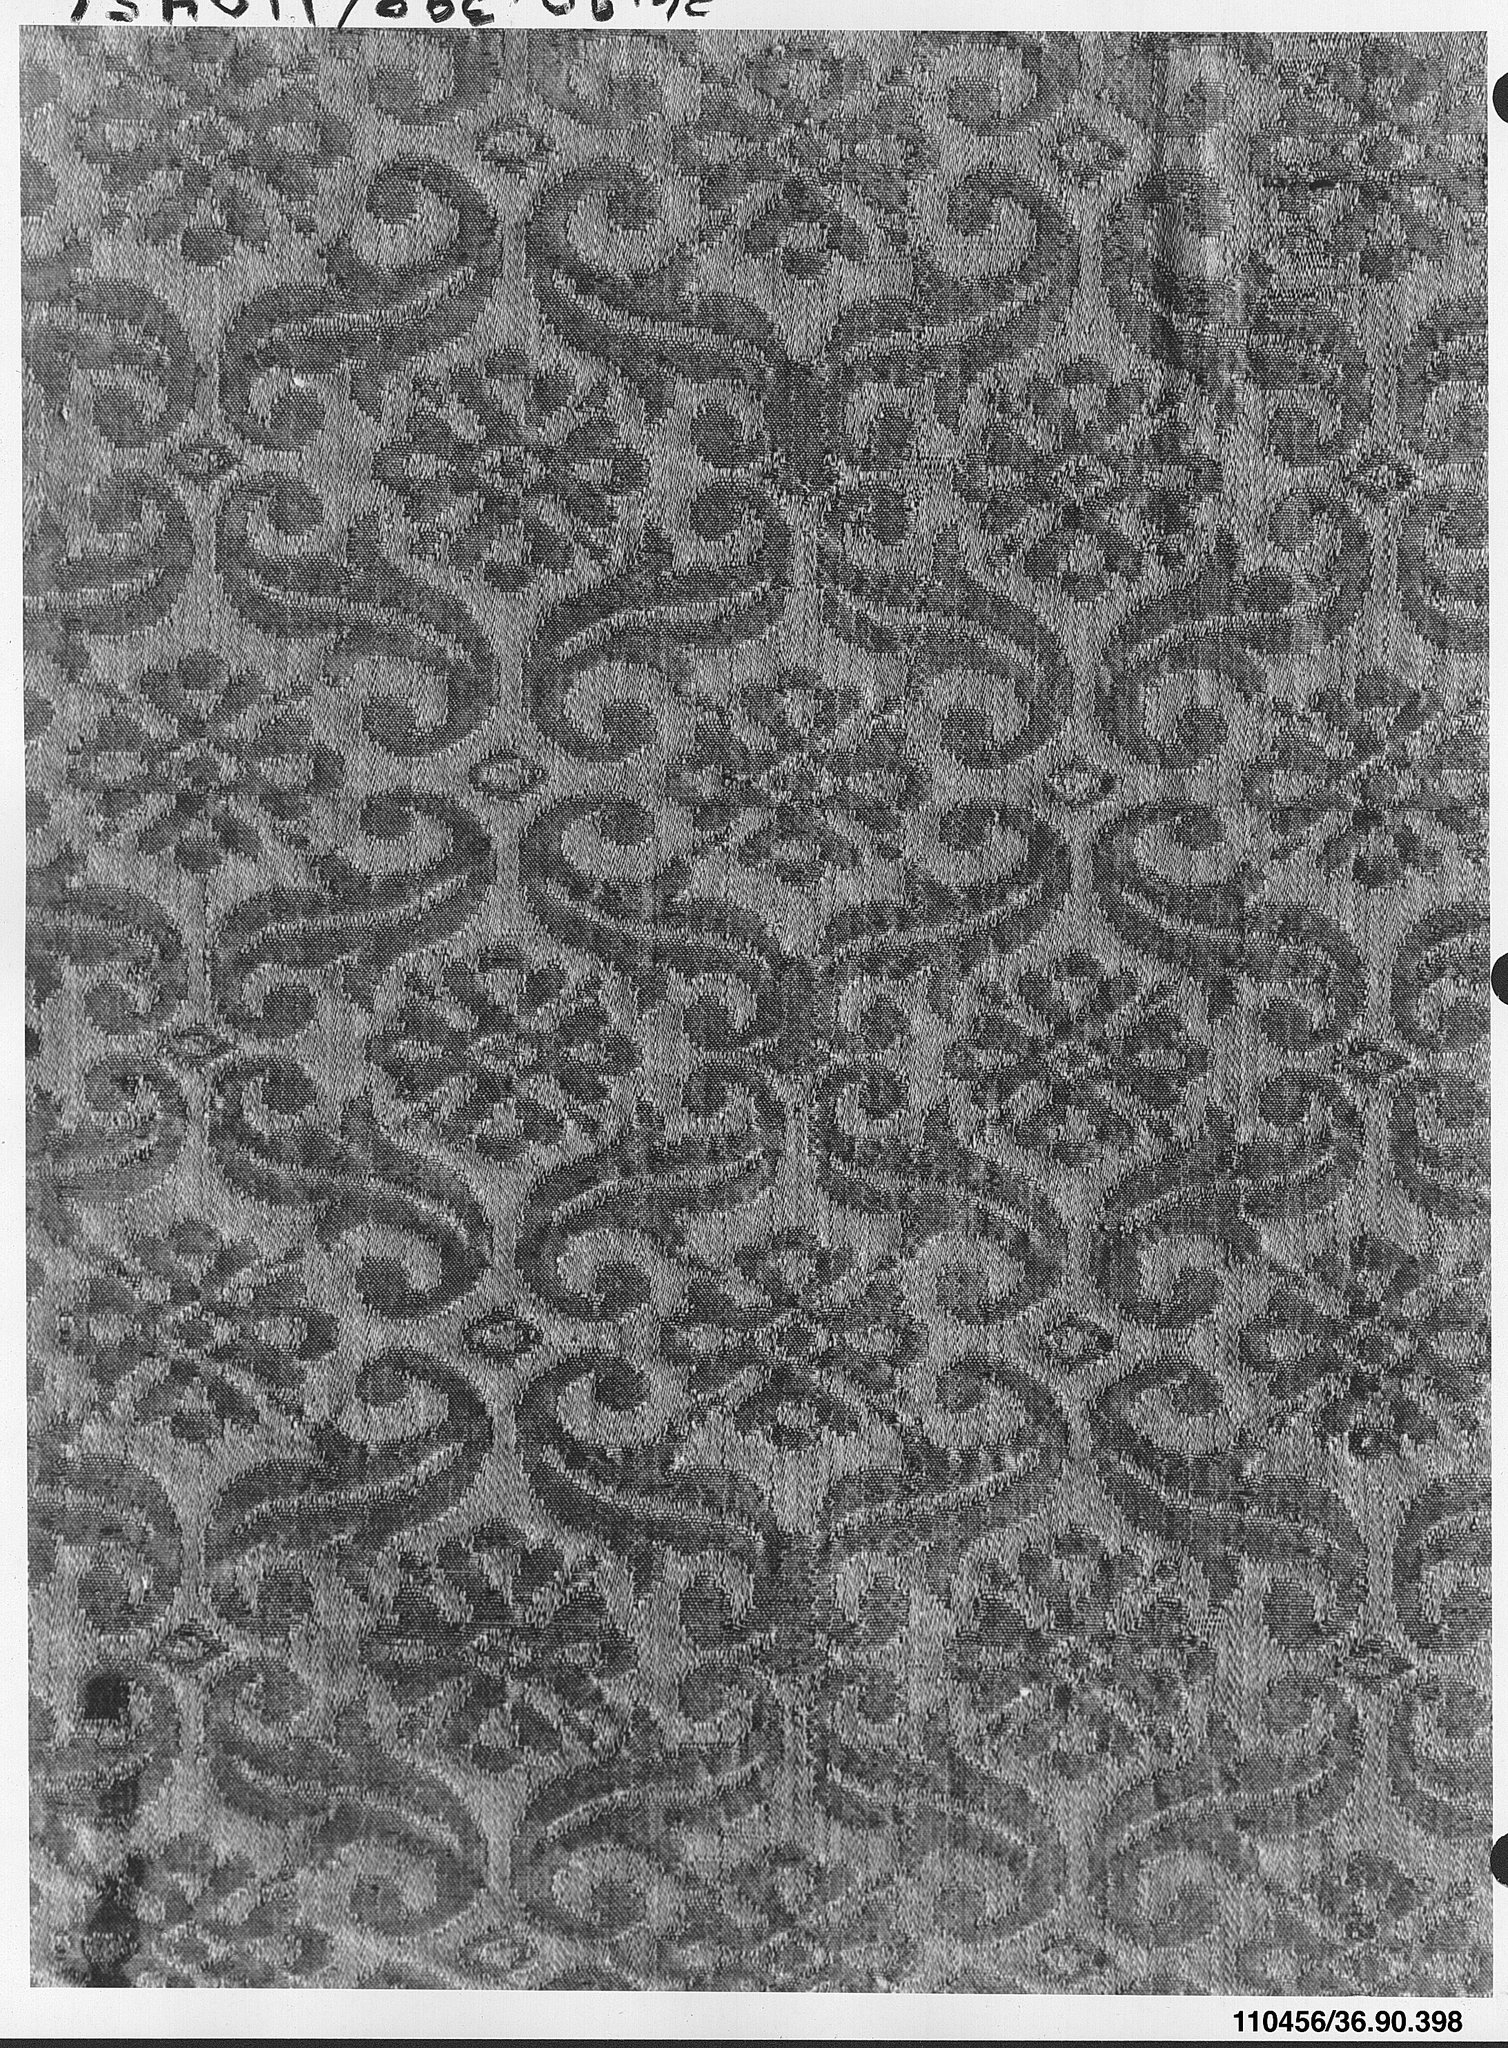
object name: piece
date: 1501-1700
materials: silk